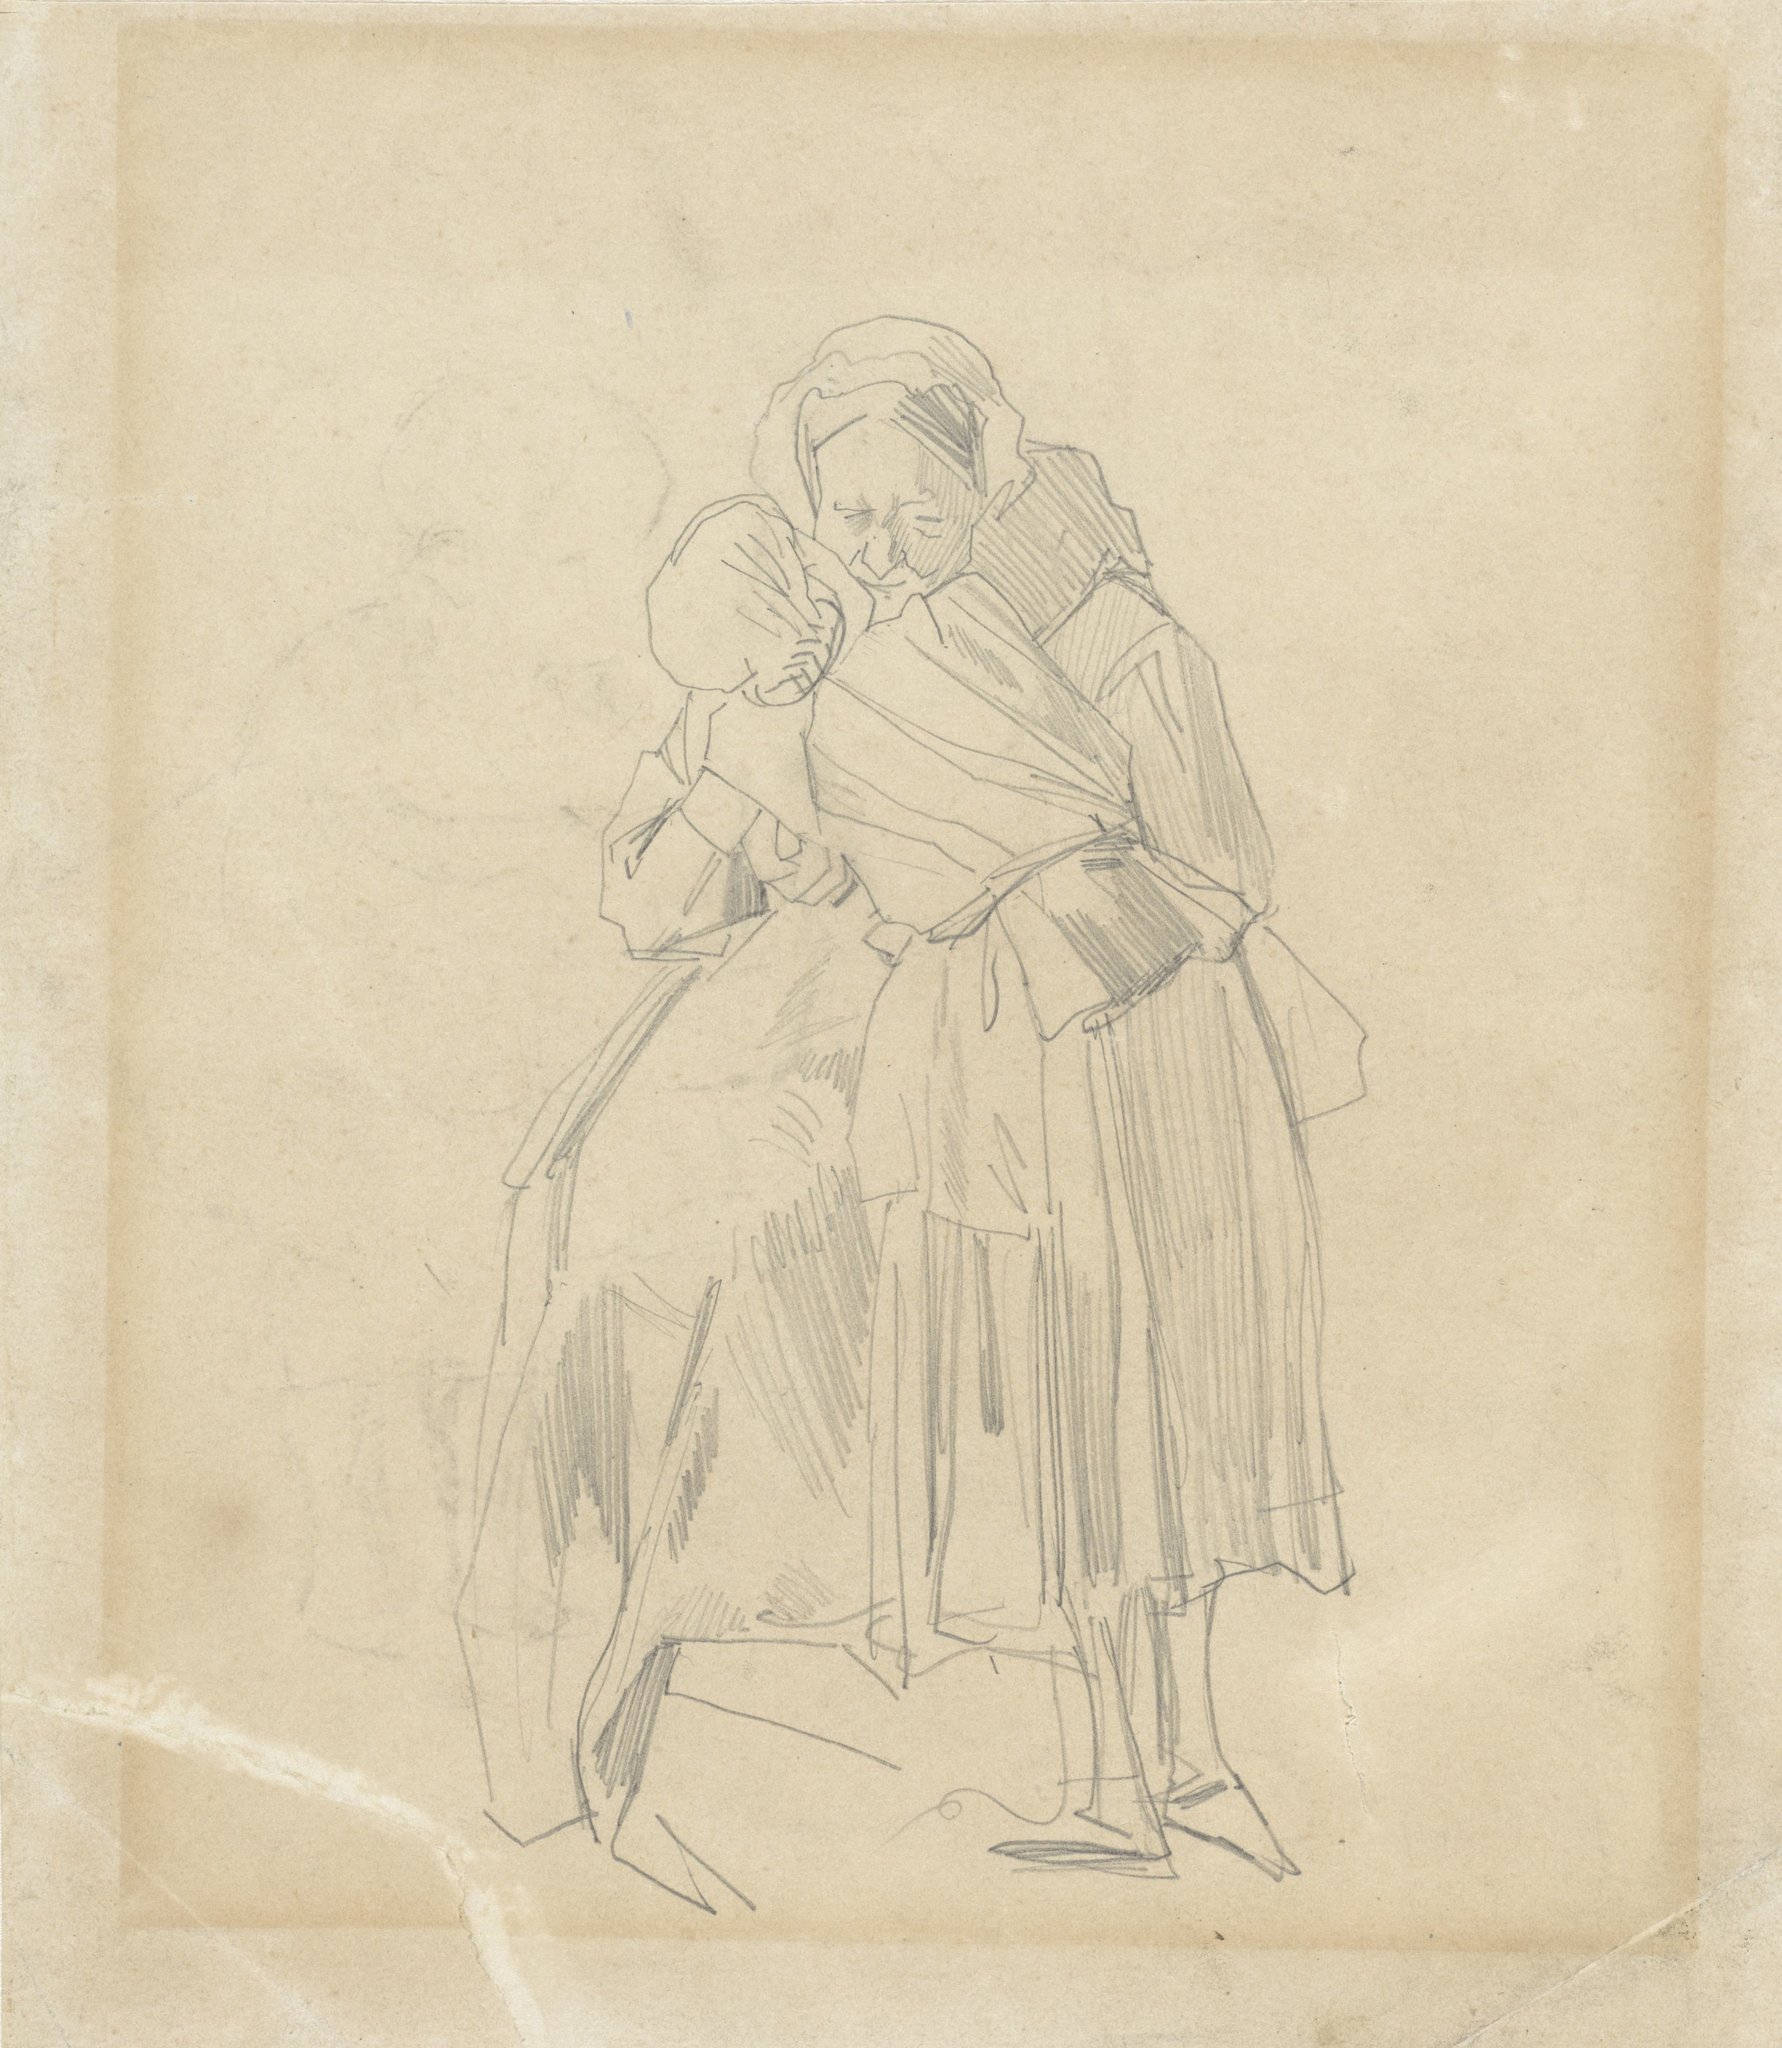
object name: drawing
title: Meisje omhelst een oude vrouw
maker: jacob maris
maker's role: draughtsman, painter, print maker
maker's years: 1837-1899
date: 1847-1899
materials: paper, pencil